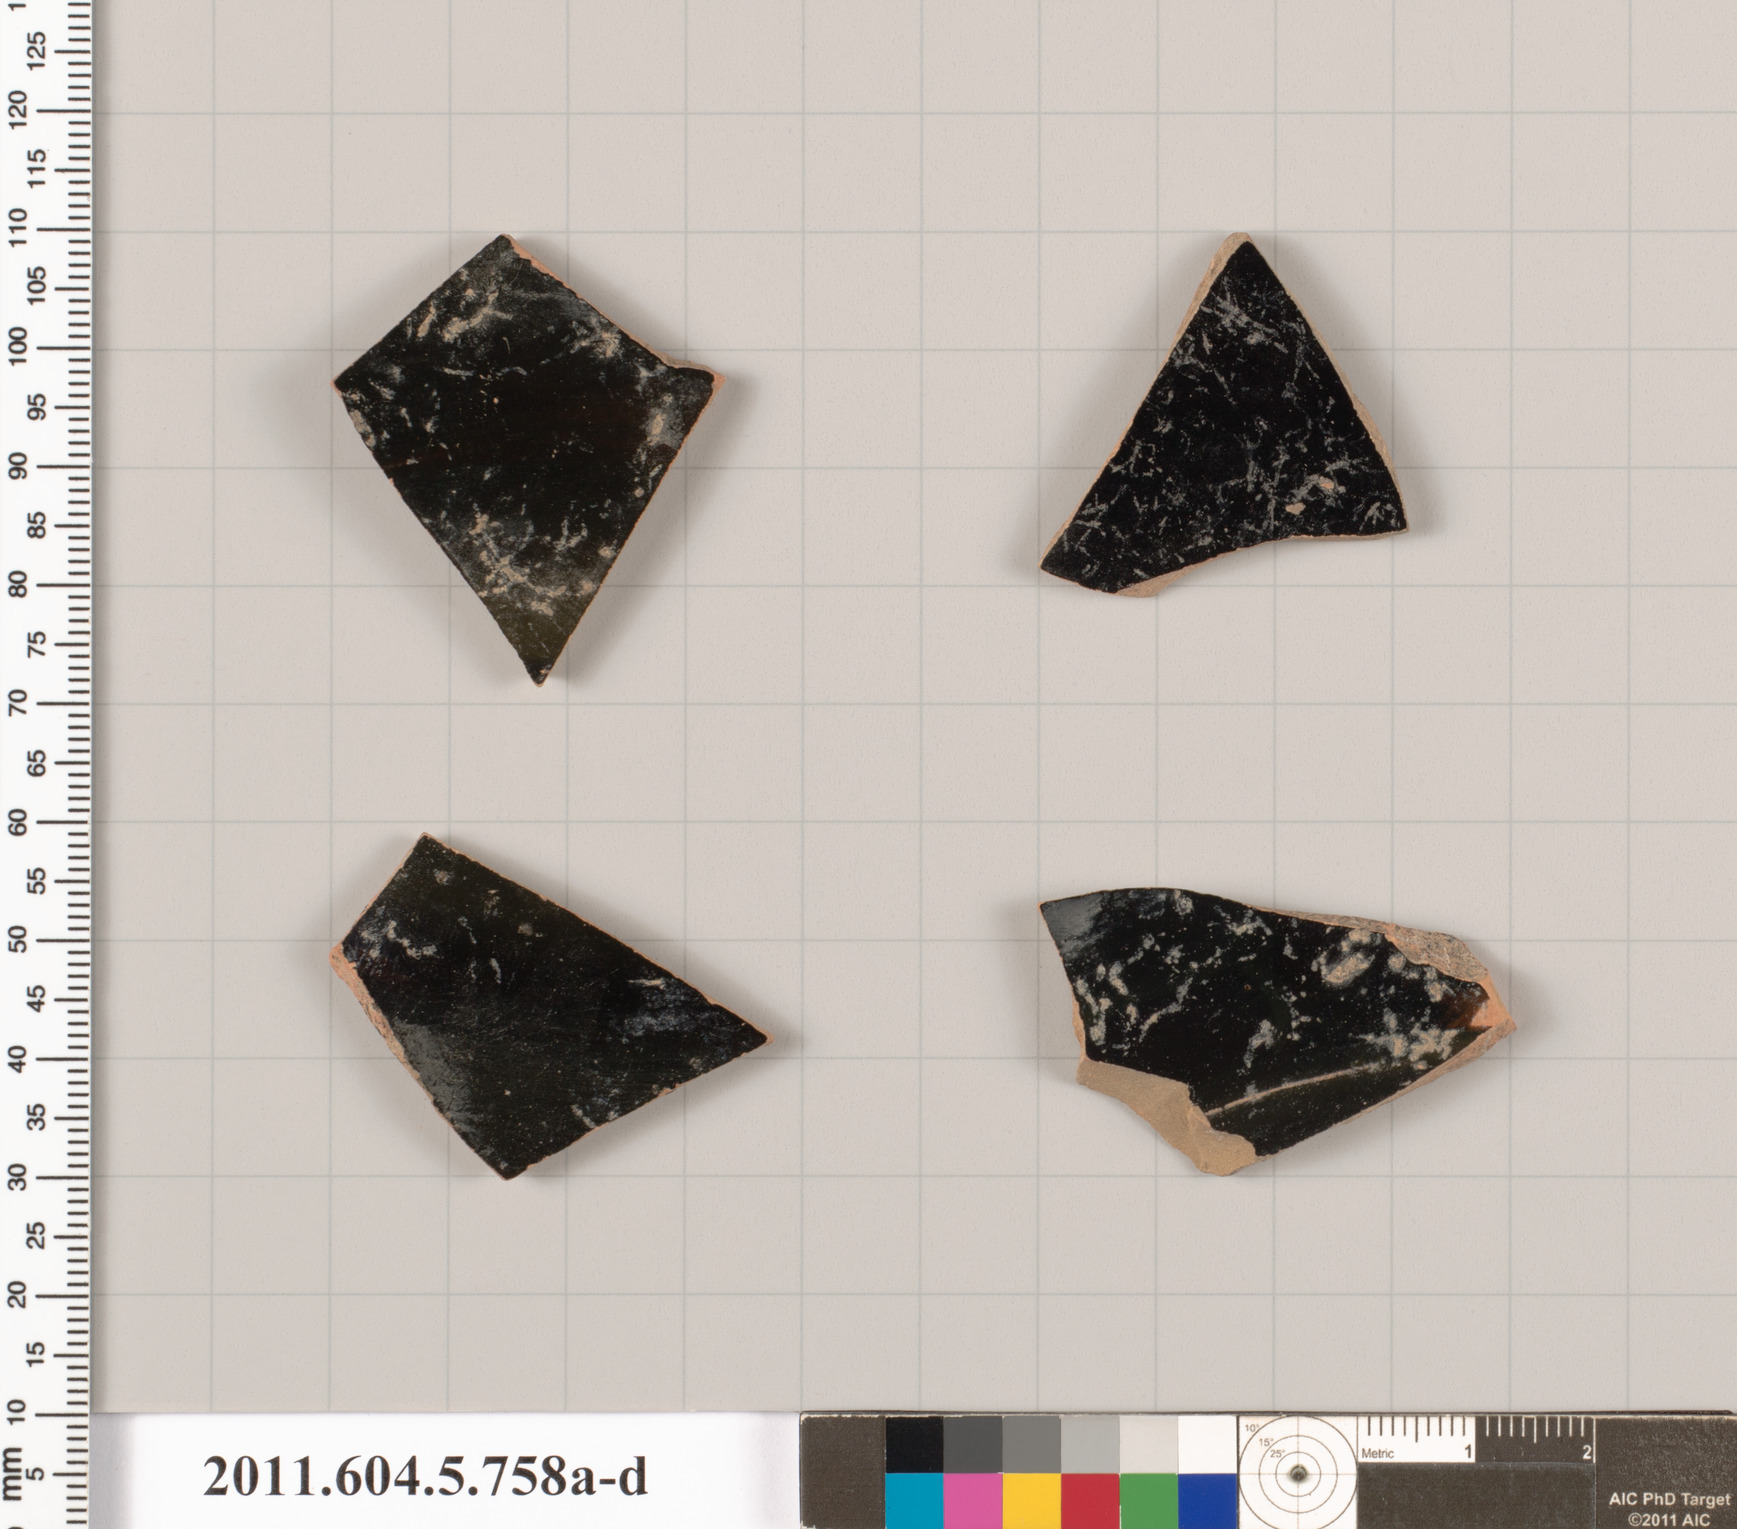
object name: kylix fragment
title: Terracotta fragments of kylikes (drinking cups)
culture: greek, attic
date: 600-401 BCE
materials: terracotta